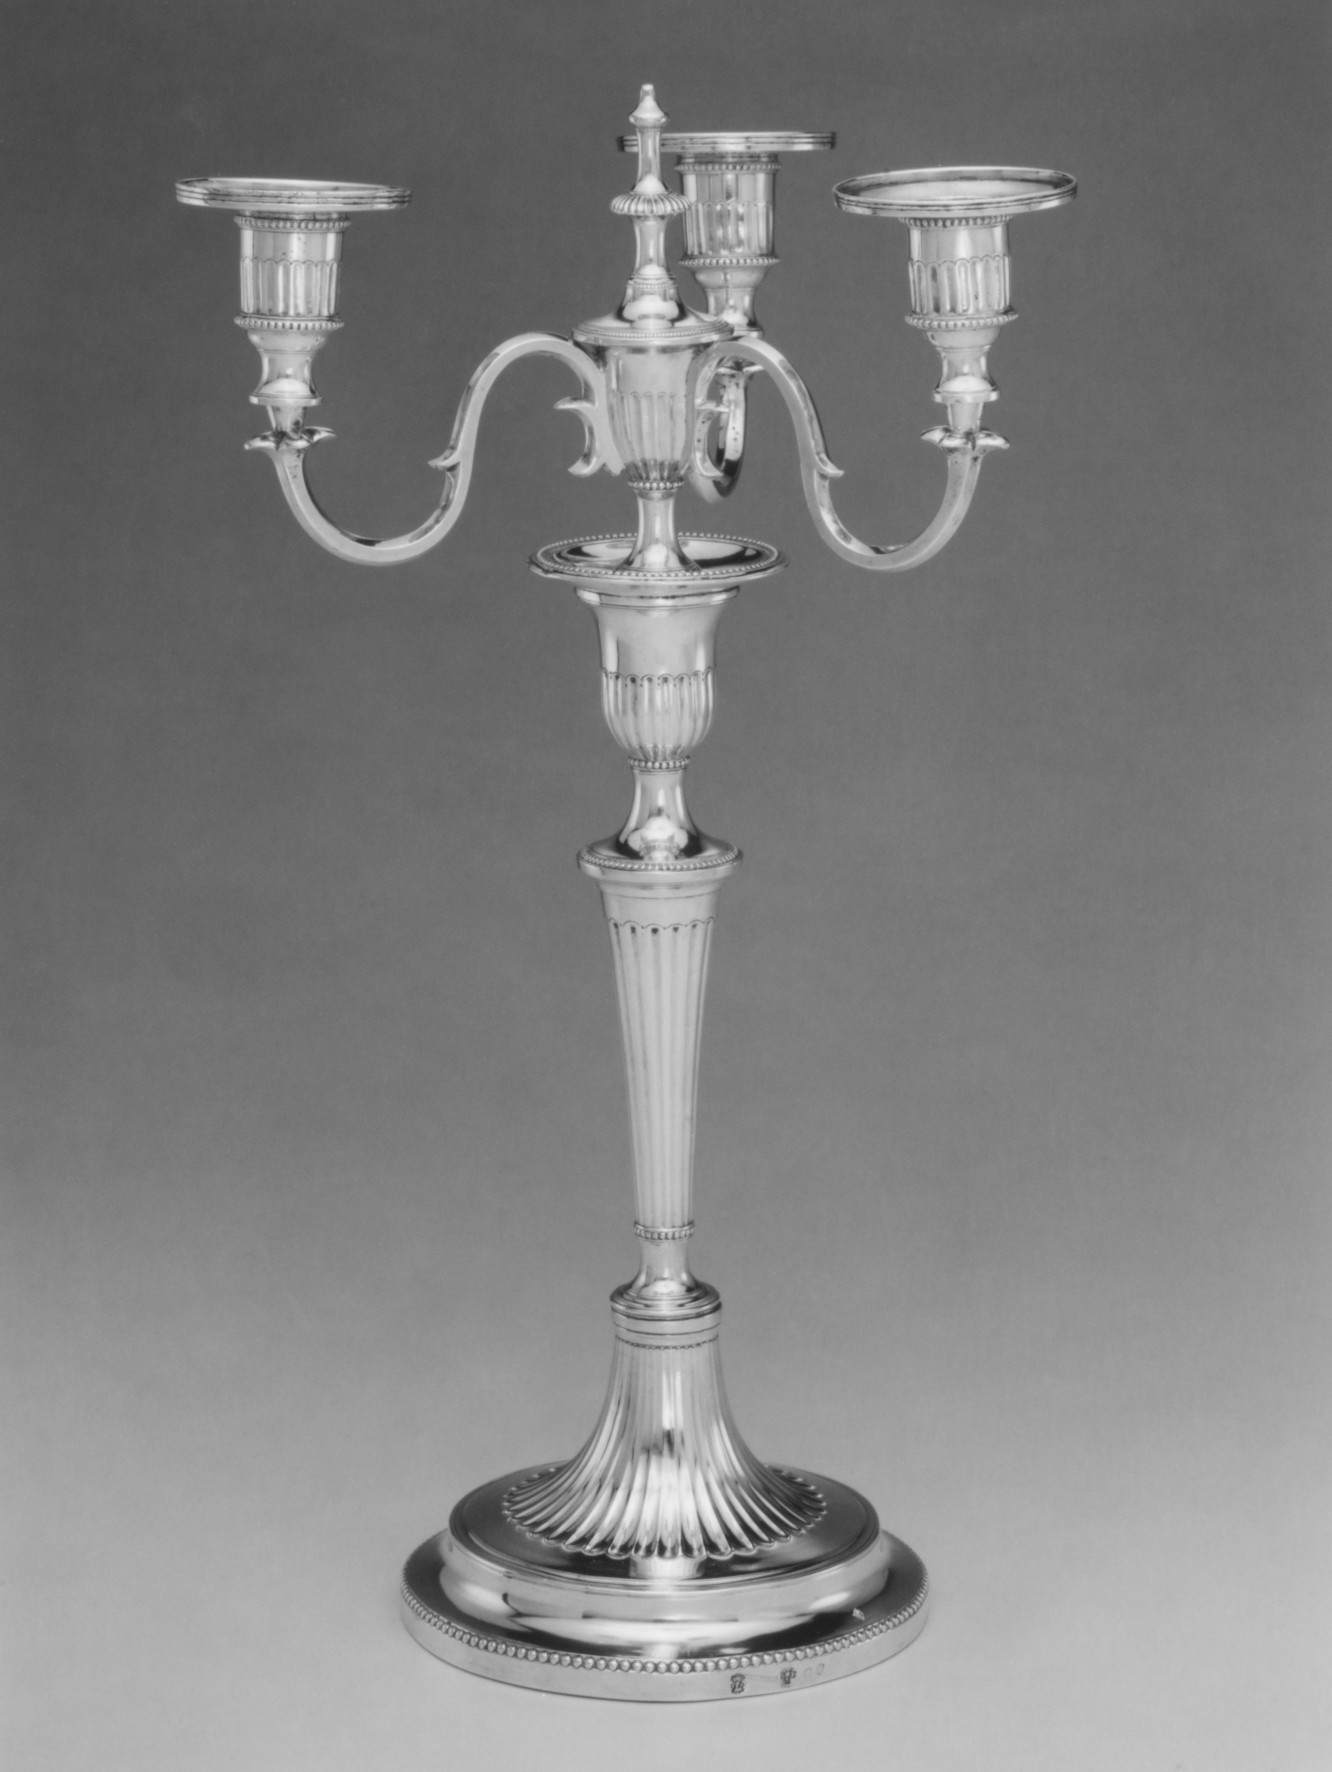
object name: candlestick with candelabrum attachment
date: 1701-1800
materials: silver